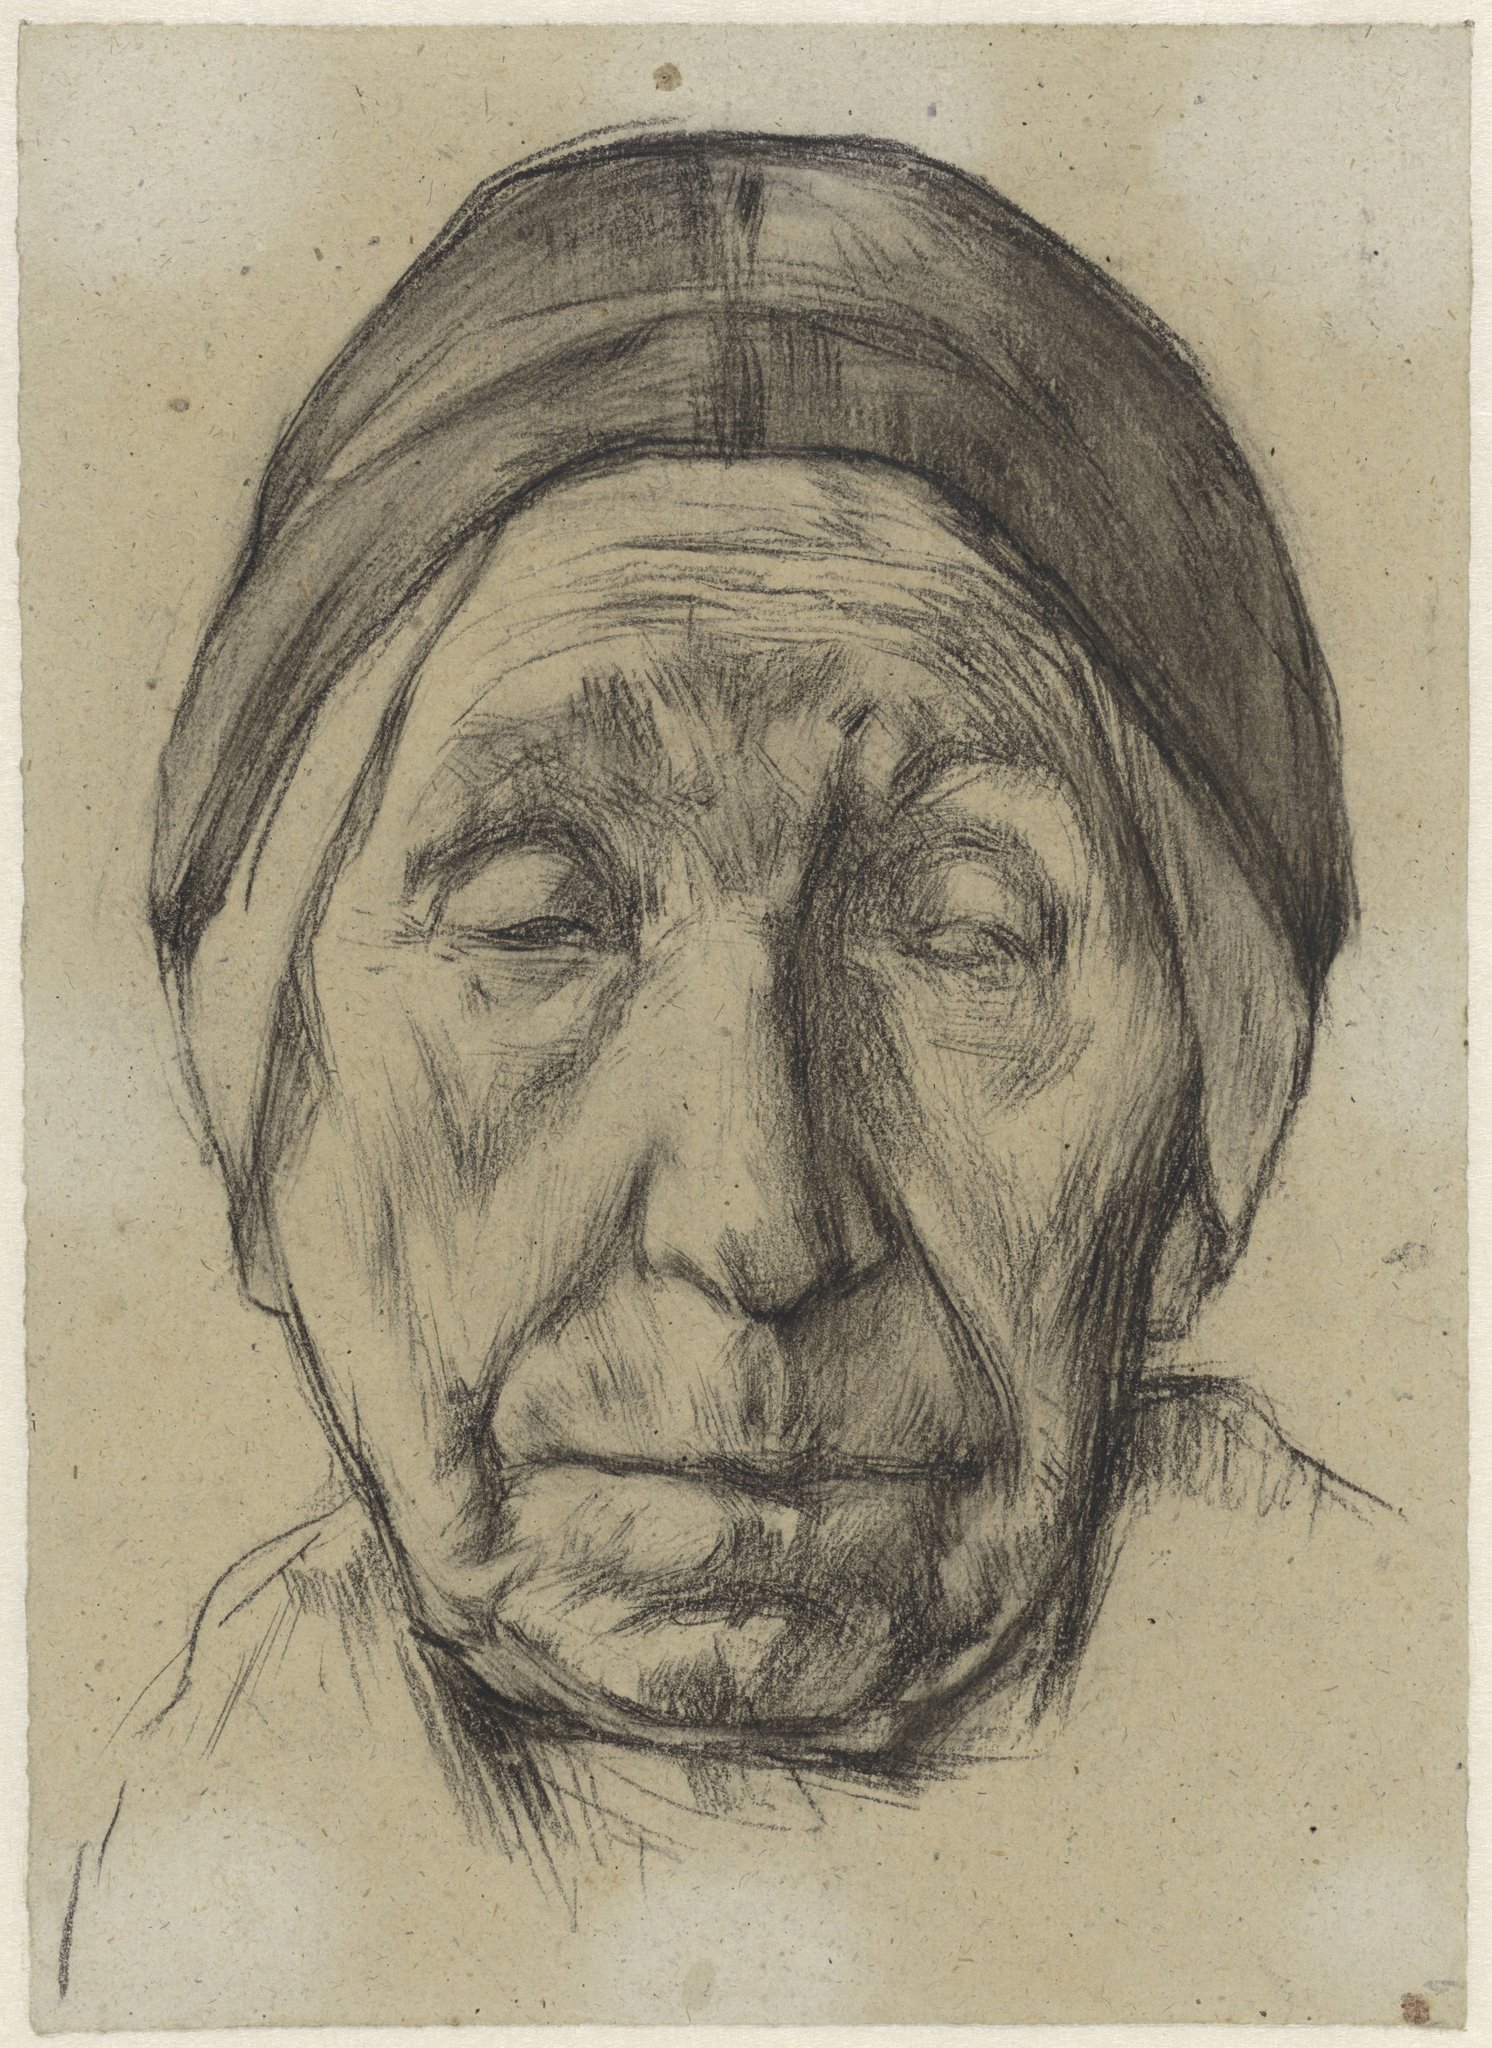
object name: drawing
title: Hoofd van Jantien Klinker, van voren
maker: anthon gerhard alexander van rappard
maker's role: draughtsman, print maker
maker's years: 1858-1892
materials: charcoal, paper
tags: anonymous historical person portrayed alone, female sex; woman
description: Model geïdentificeerd door: Egbert Brink, Ridder in het armenhuis. Anthon van Rappard in Drenthe, Waardeel, Drents Historisch Tijdschrift 25-1 (2005), pp. 23-28. een schilderij van hetzelfde model is aanwezig in het Van Gogh-museum, inv. nr. s353; mededeling van Hans Luijten